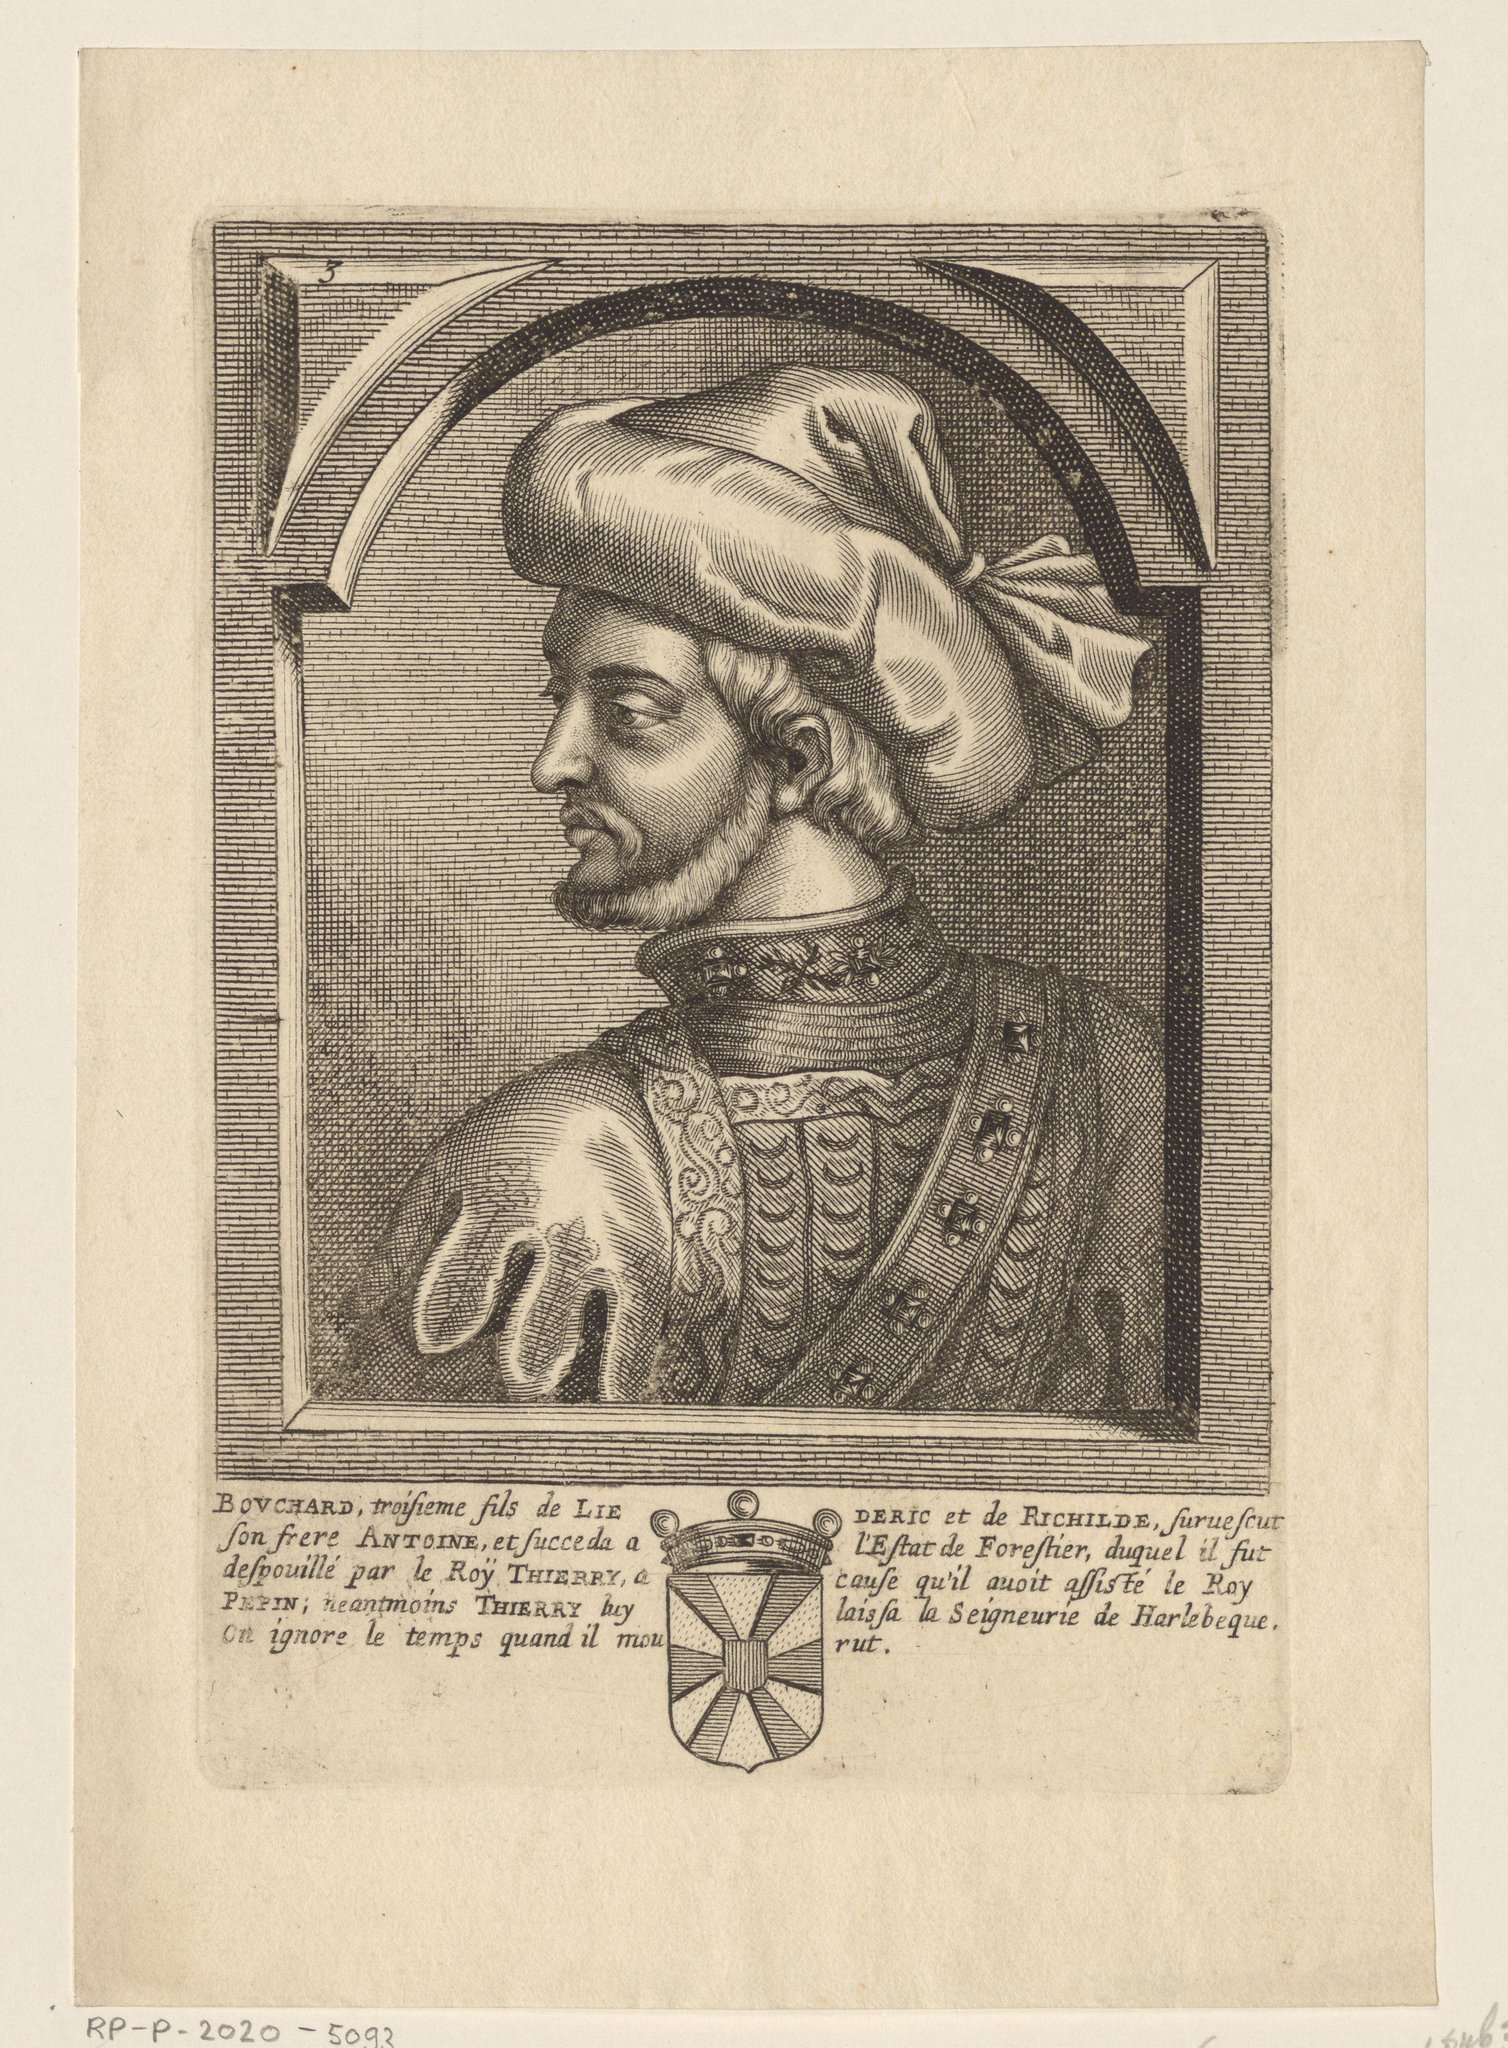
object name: print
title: Portretten van de graven van Vlaanderen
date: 1663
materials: paper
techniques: engraving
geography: antwerp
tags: armorial bearing, heraldry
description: Tweede zoon van Liederik van Vlaanderengouw. Linksboven genummerd: 3.